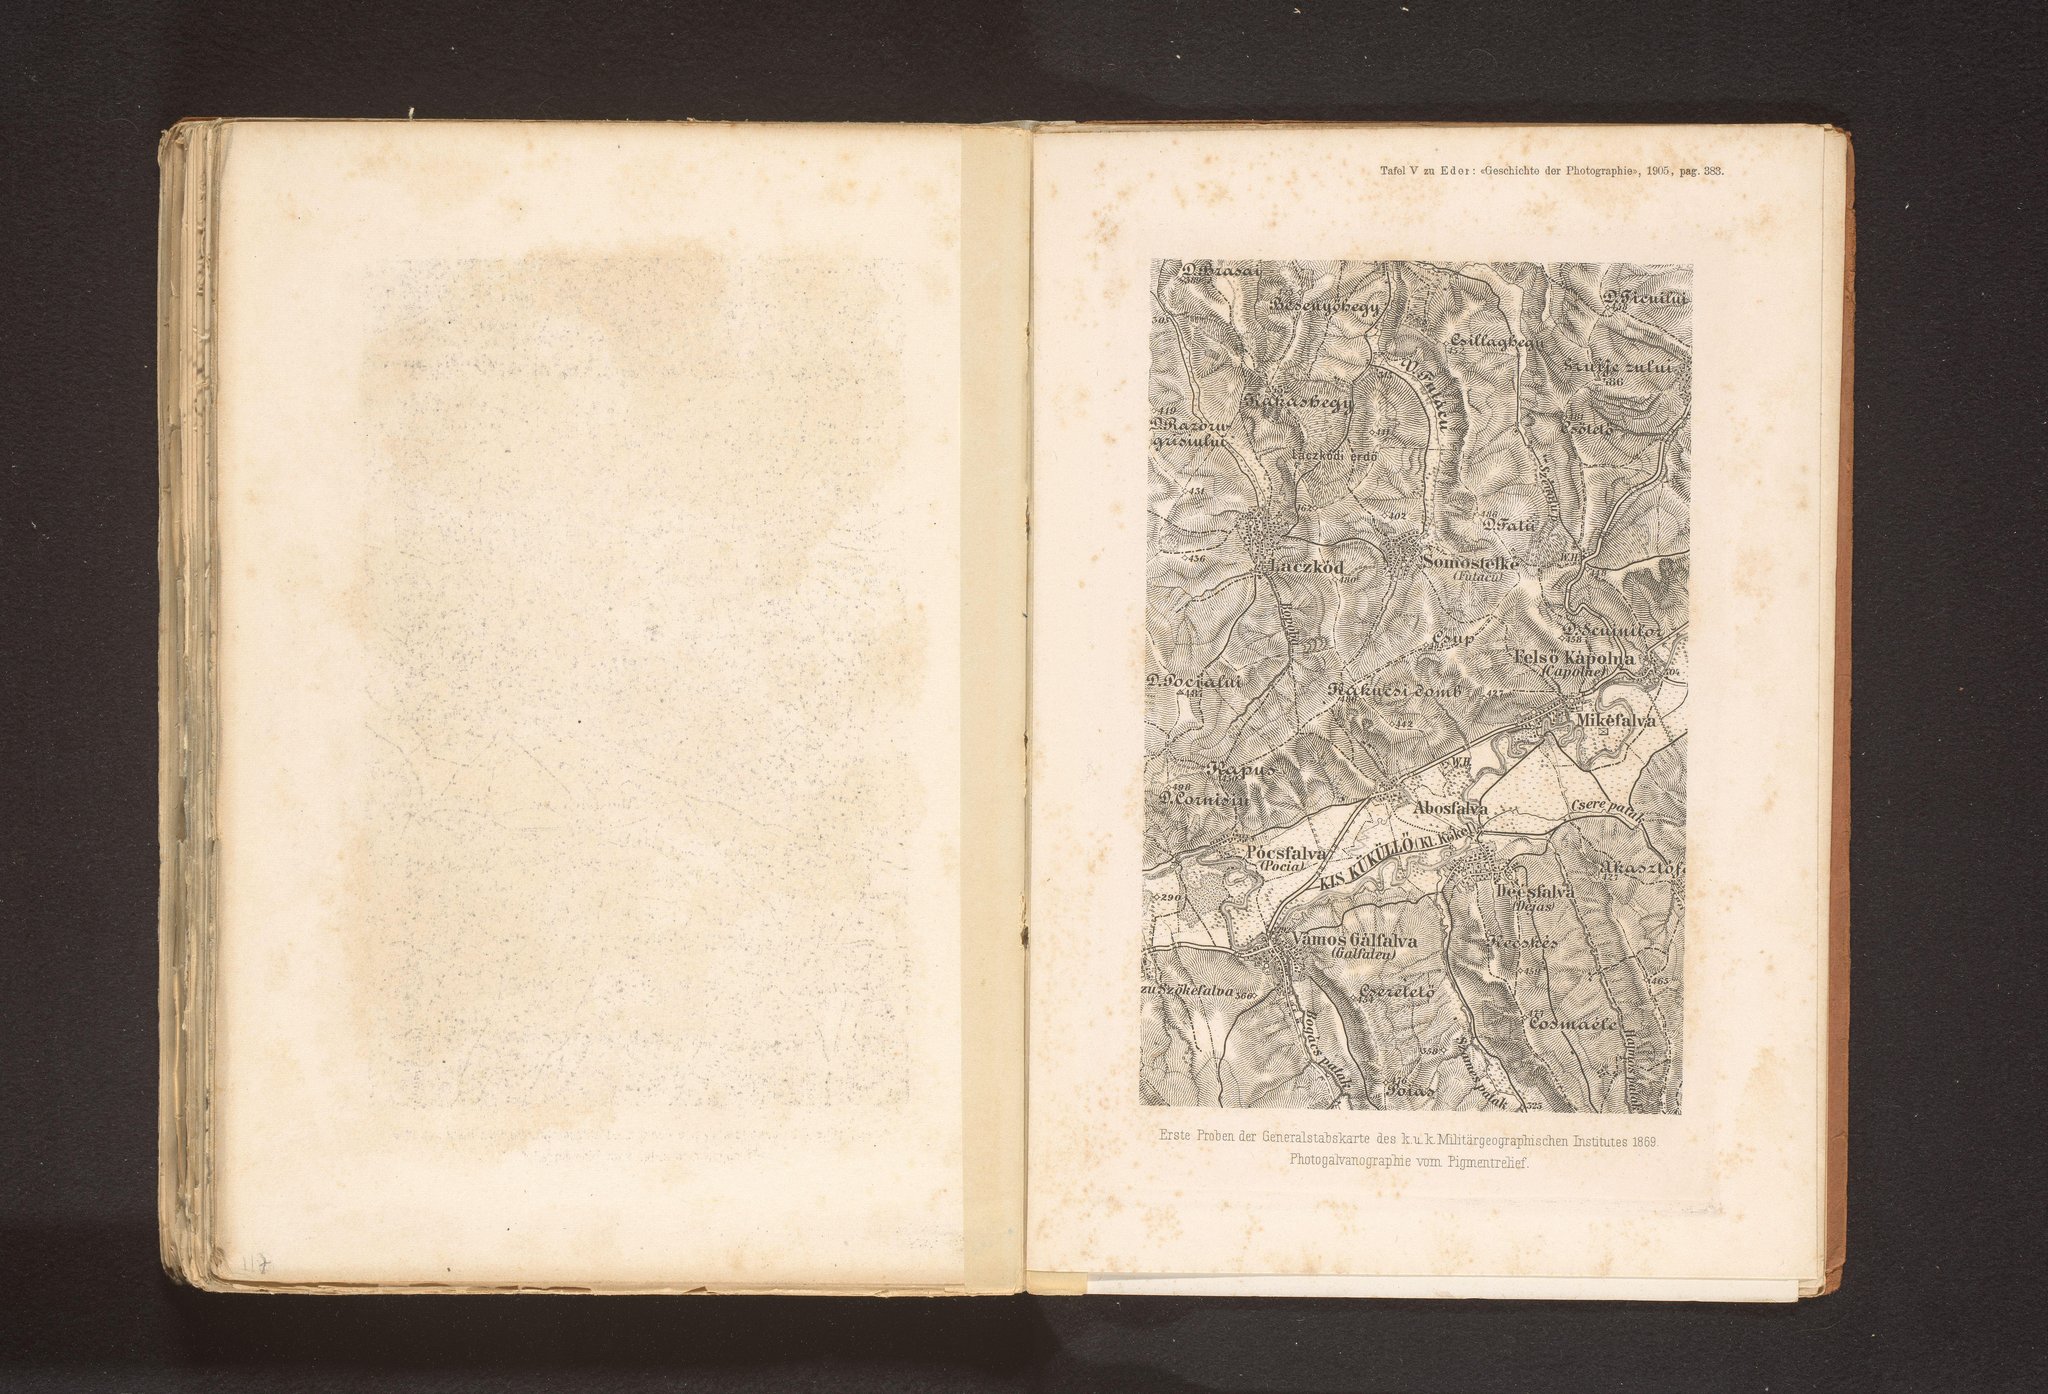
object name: photomechanical print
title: Fotoreproductie van een kaart van het gebied rond Kis-Küküllő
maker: Anonymous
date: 1900-1905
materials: paper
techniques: photogalvanography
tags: maps, atlases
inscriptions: number: ‘Tafel V’, inscription: ‘Erste Proben der Generalstabskarte des k. u. k. (...) 1869’